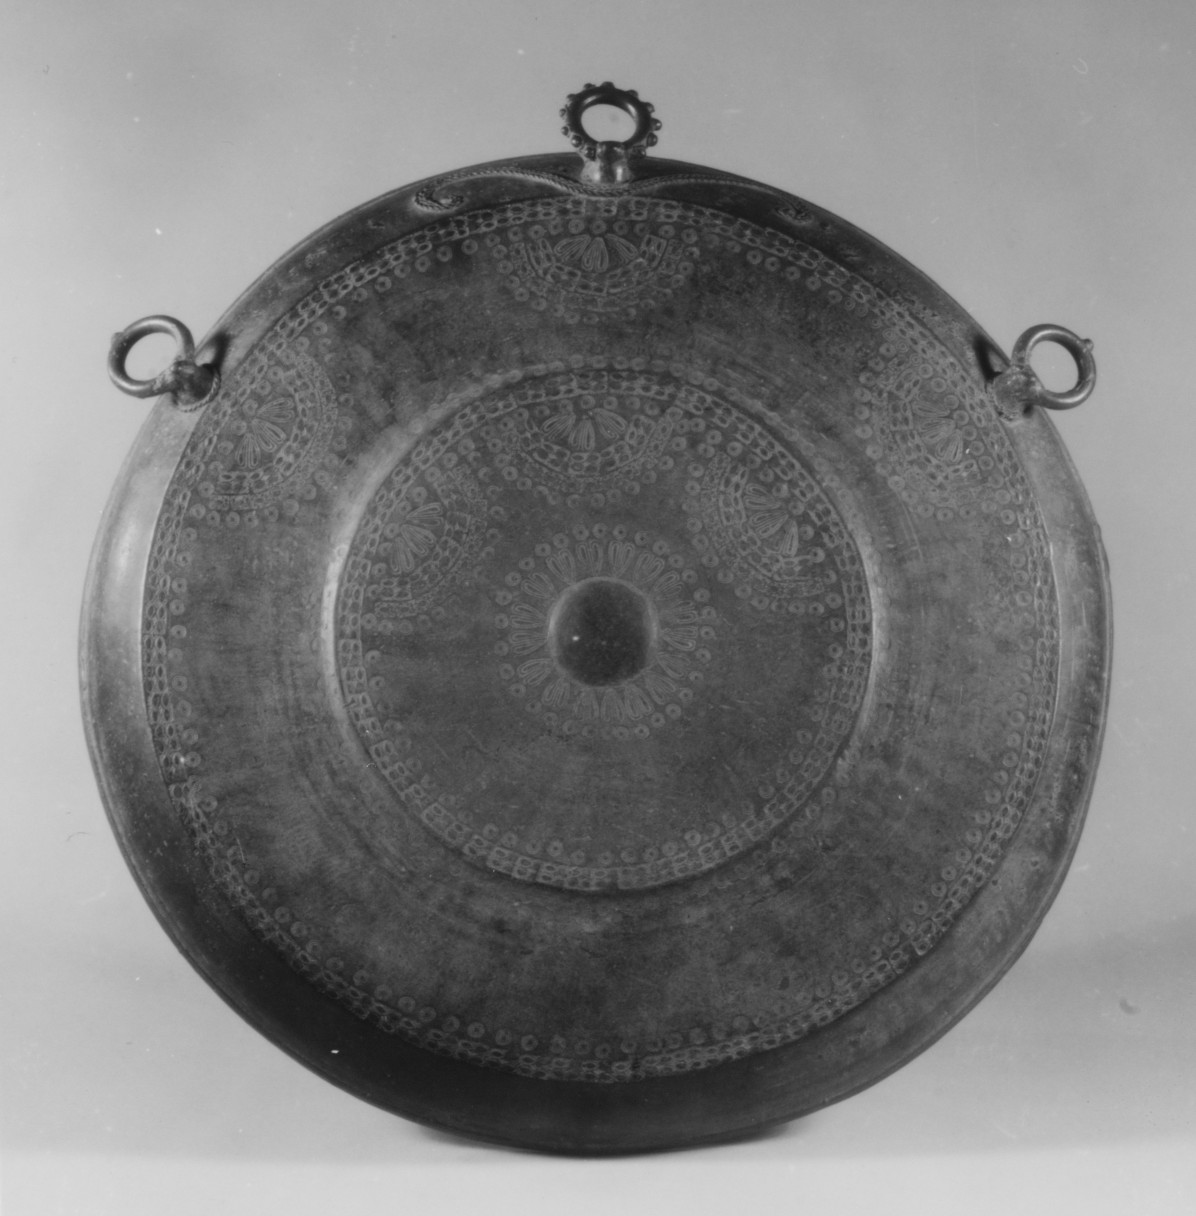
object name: gong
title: Gong with Three Ring Supports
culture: burmese or thai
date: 901-1200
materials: bronze